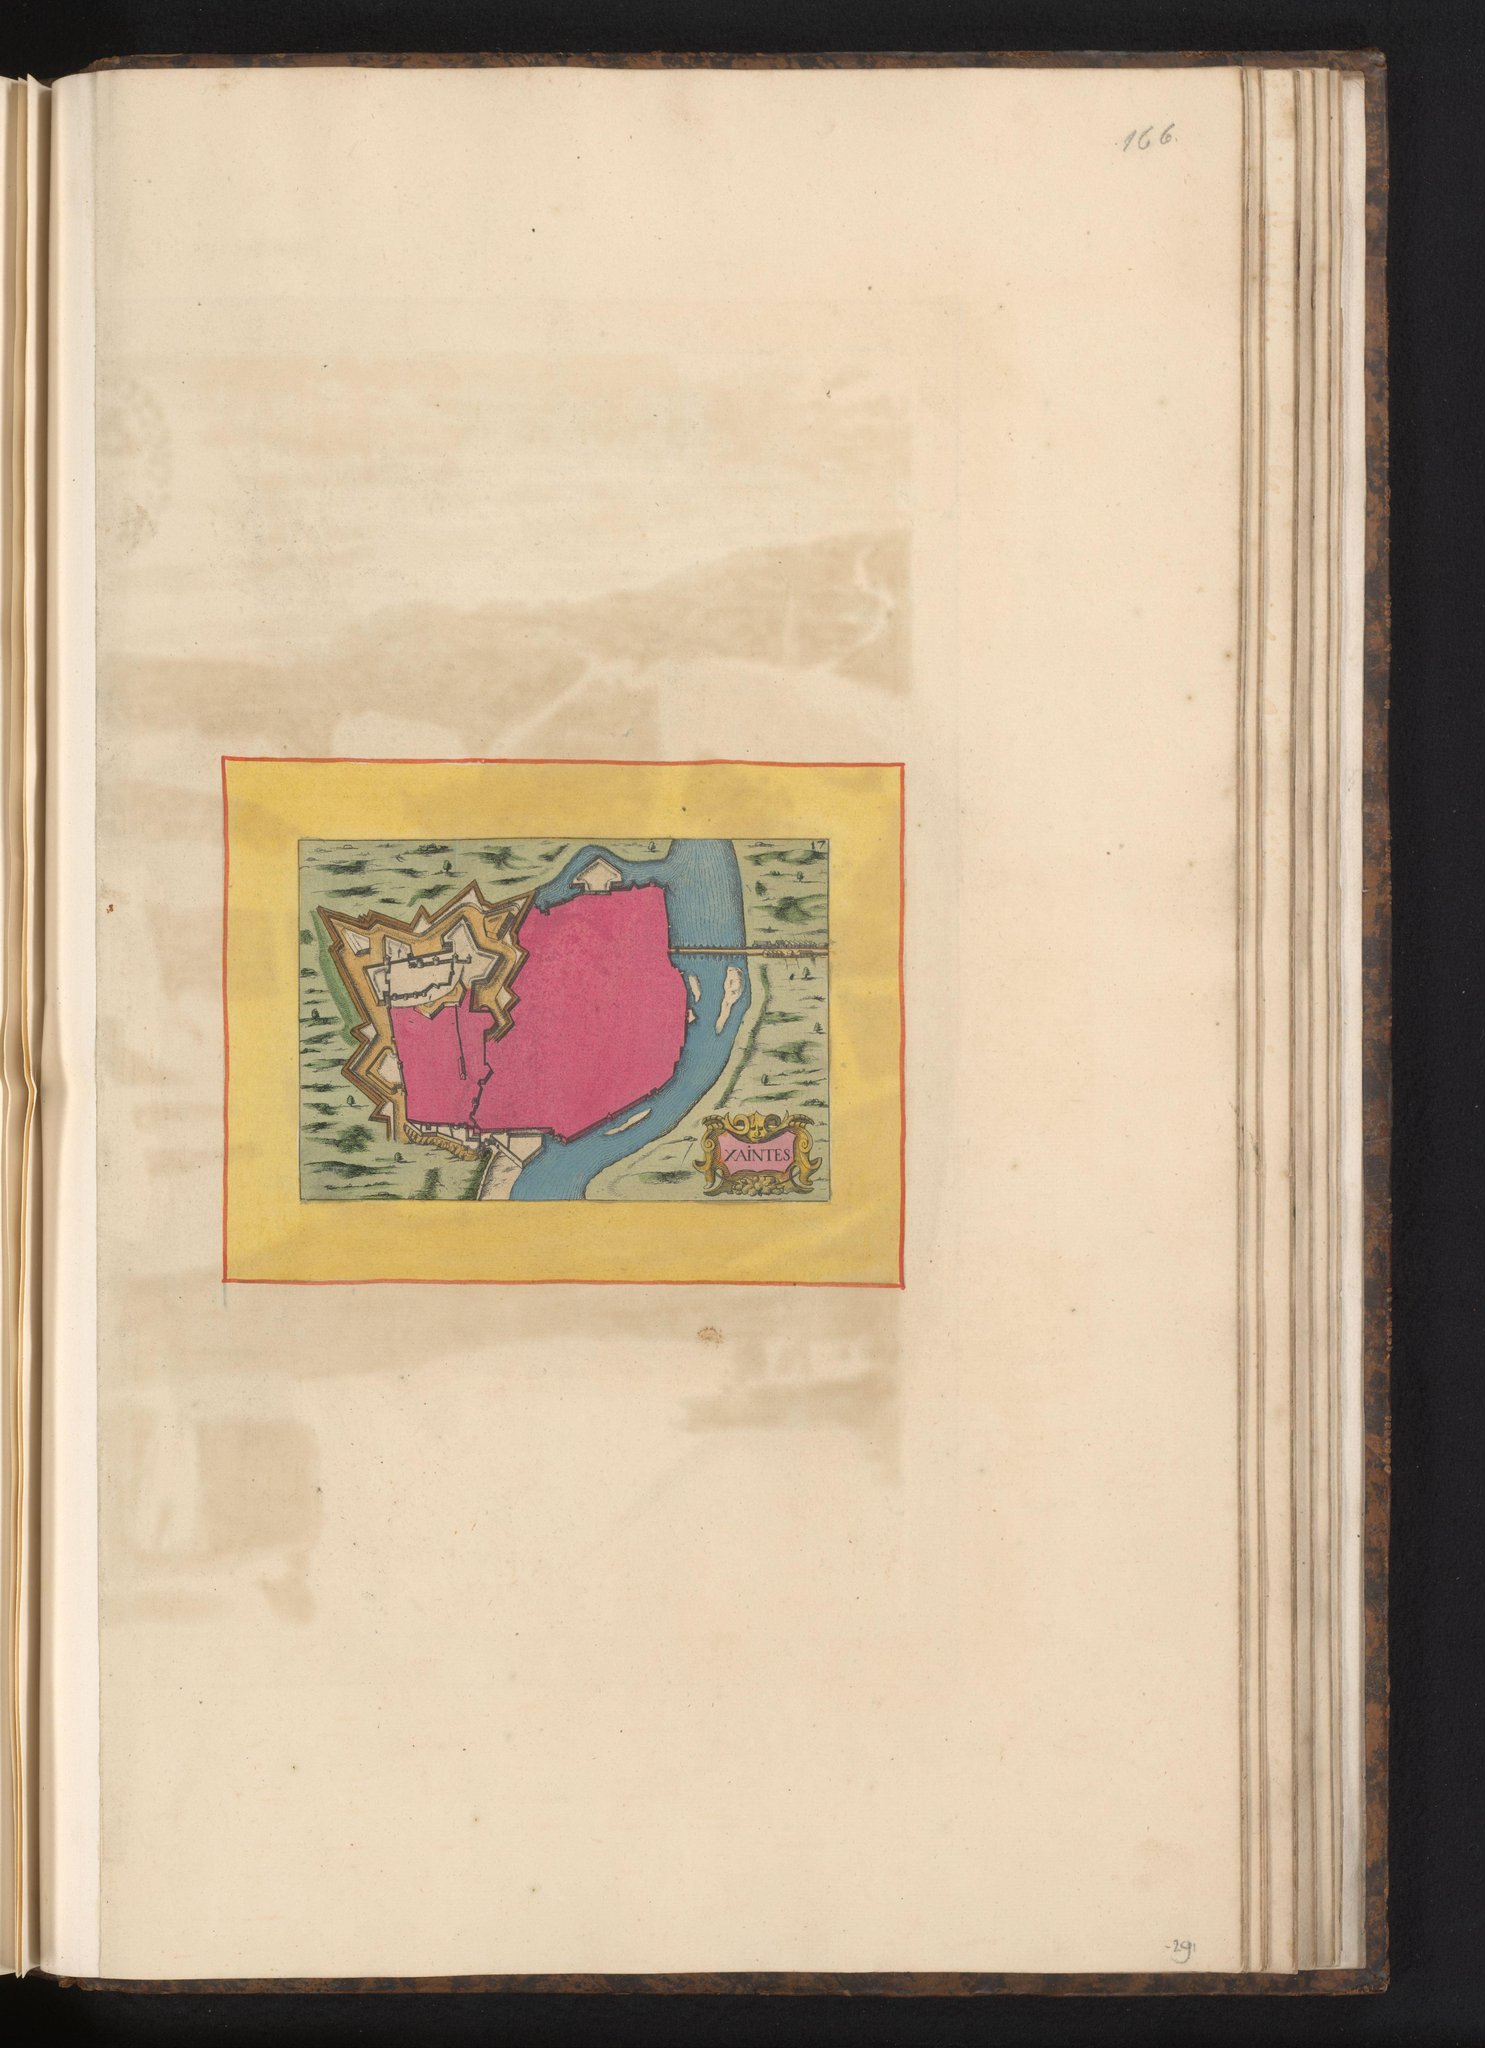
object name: area plan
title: Vestingplattegrond van Saintes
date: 1638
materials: paper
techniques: engraving, etching, hand coloring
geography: the hague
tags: maps of cities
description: Prent uit: Tassin, Christophe. Les plans et profils de toutes les principales villes et lieux considérables de France (...). Parijs: Michel van Lochom, 1638, prent 17 uit het deel 'Poictou'.